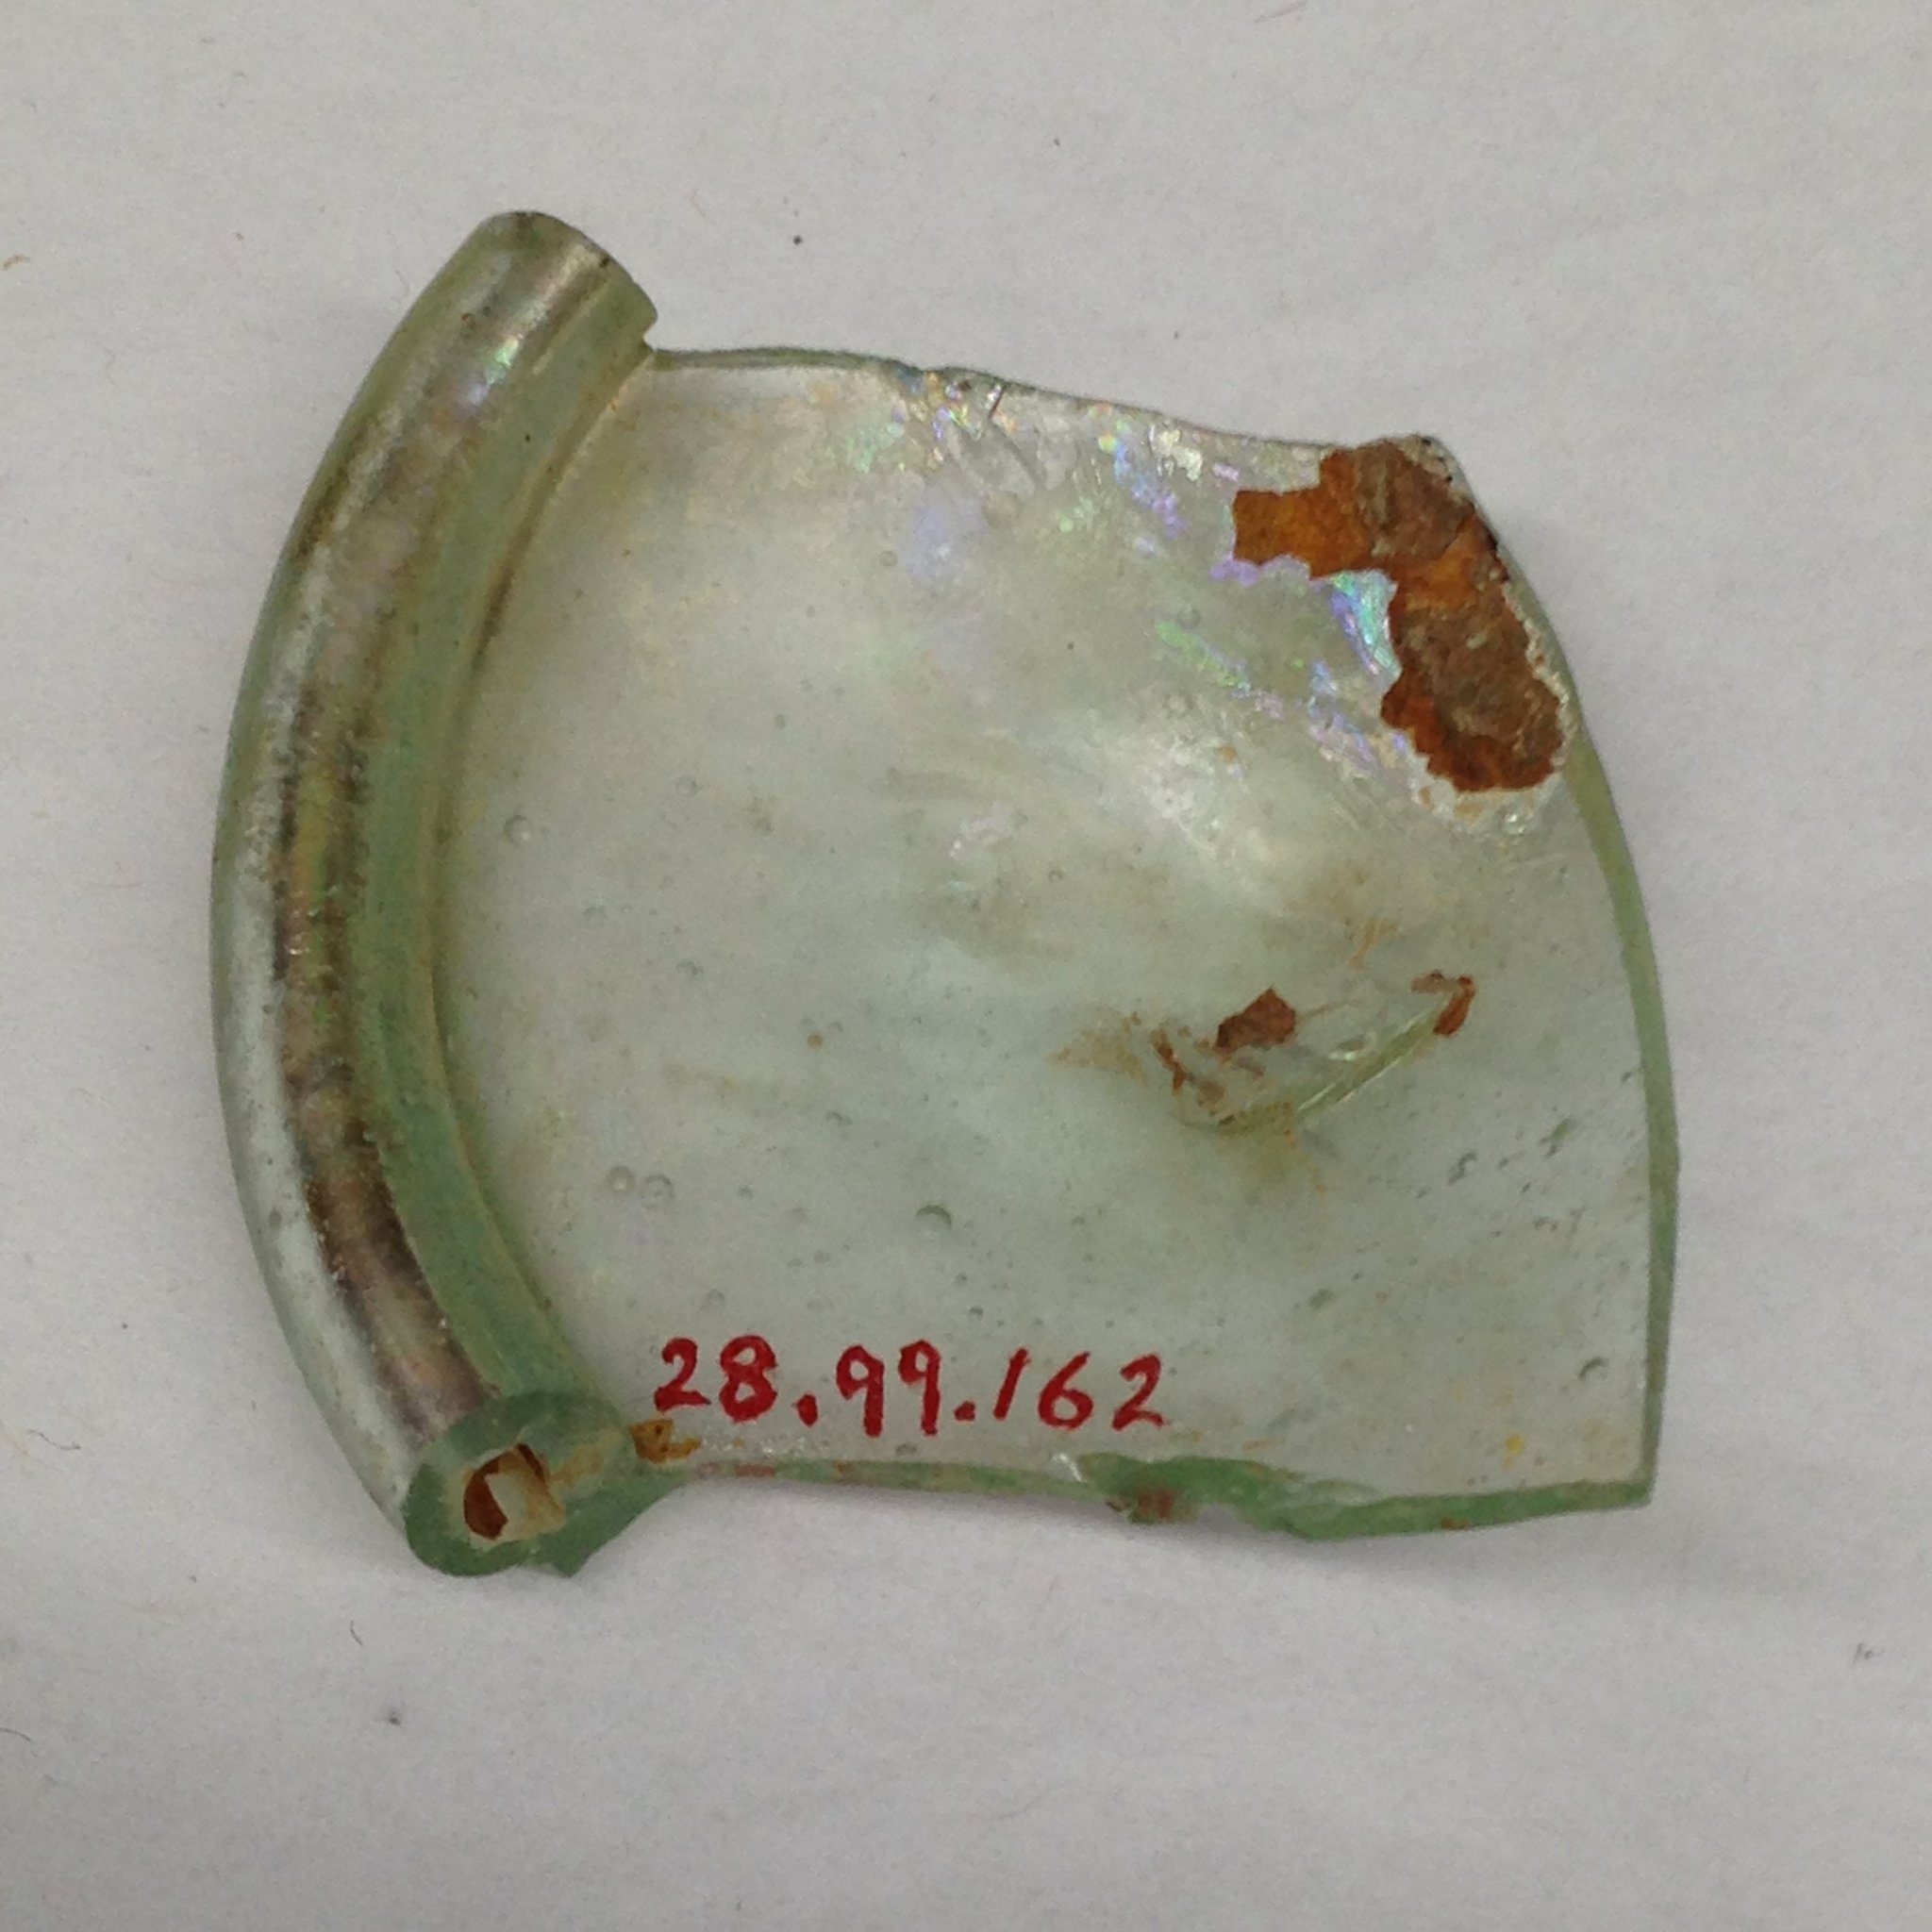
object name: fragment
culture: european or middle eastern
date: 1150-1250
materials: ceramic, glass